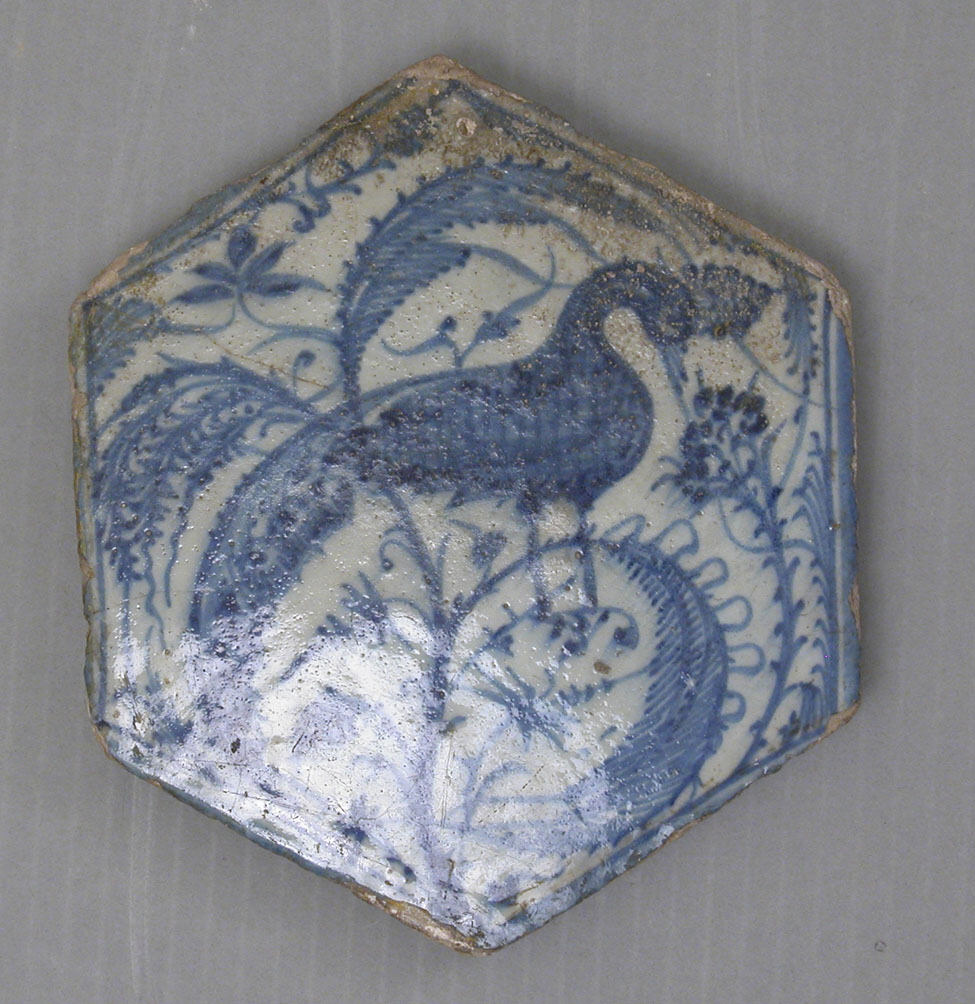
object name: tile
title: Hexagonal Tile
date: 1401-1500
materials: stonepaste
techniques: painting, underglaze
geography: egypt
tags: birds